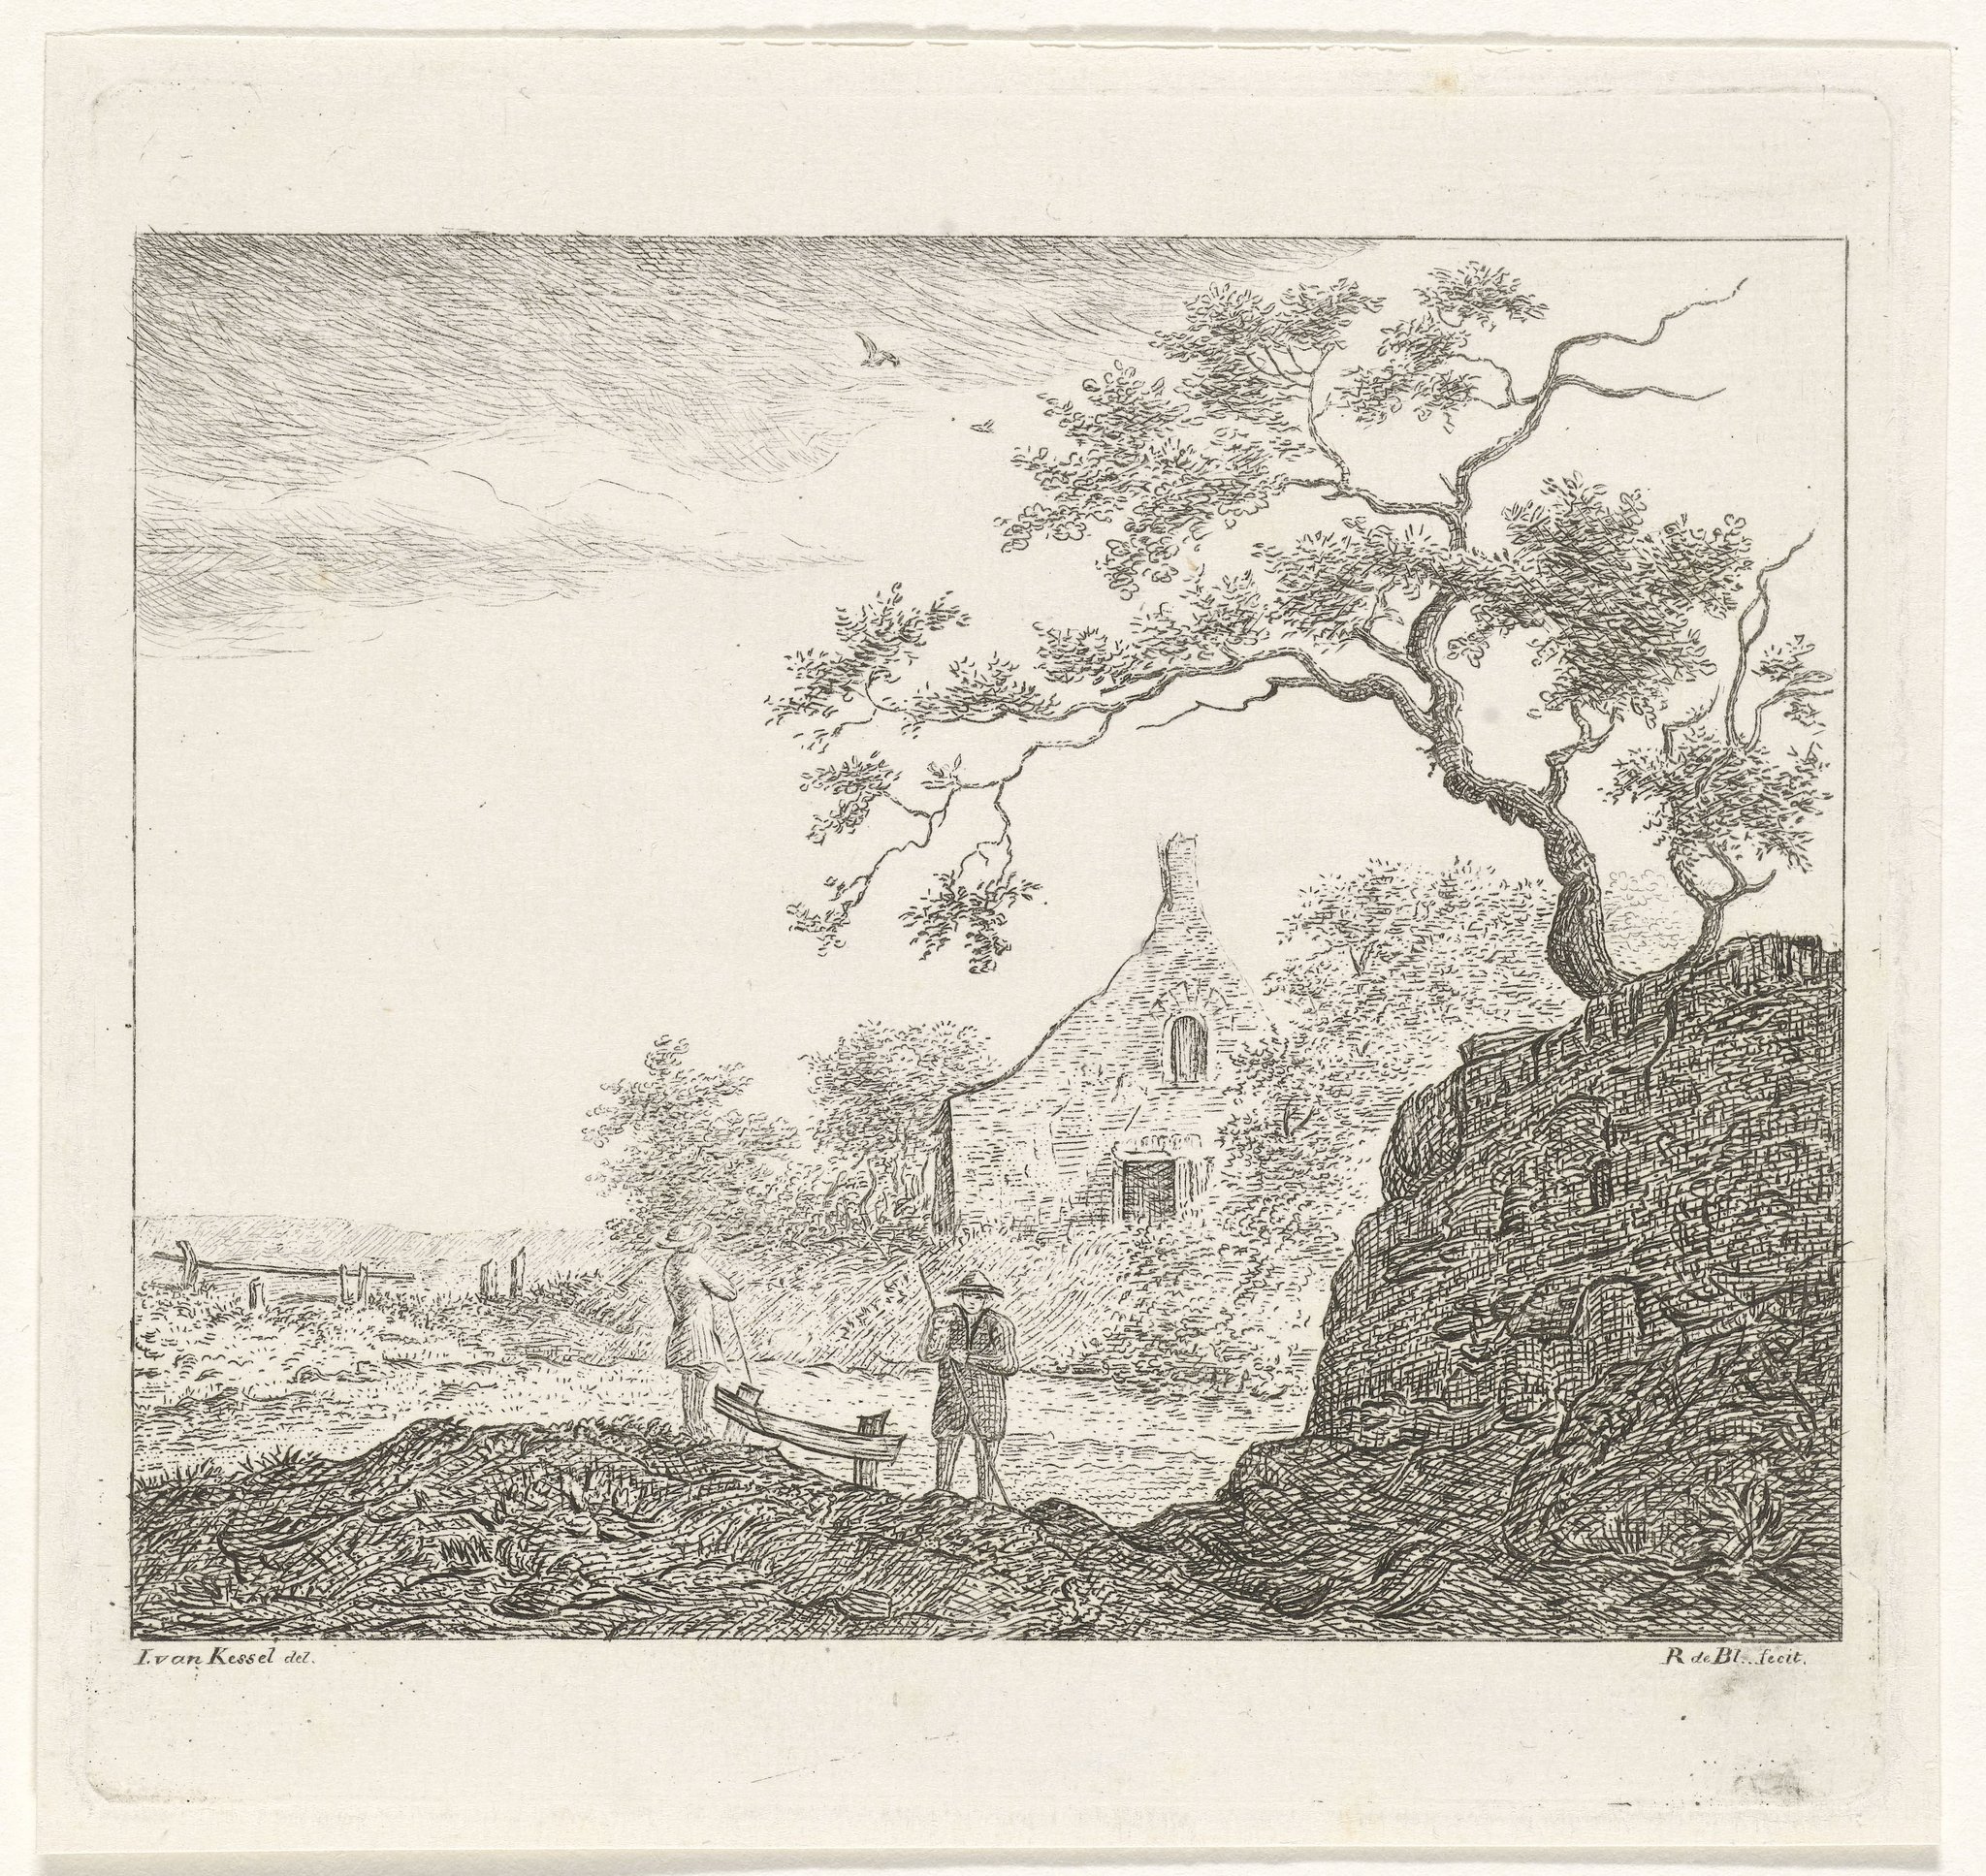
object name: print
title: Landschap met figuren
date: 1796-1856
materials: paper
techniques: etching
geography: vaassen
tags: landscapes (+ landscape with figures, staffage), farm or solitary house in landscape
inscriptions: collector's mark: Lugt 2228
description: Twee mannen bij een hek in een landschap. Rechts een boom op een heuvel, op de achtergrond een woning.